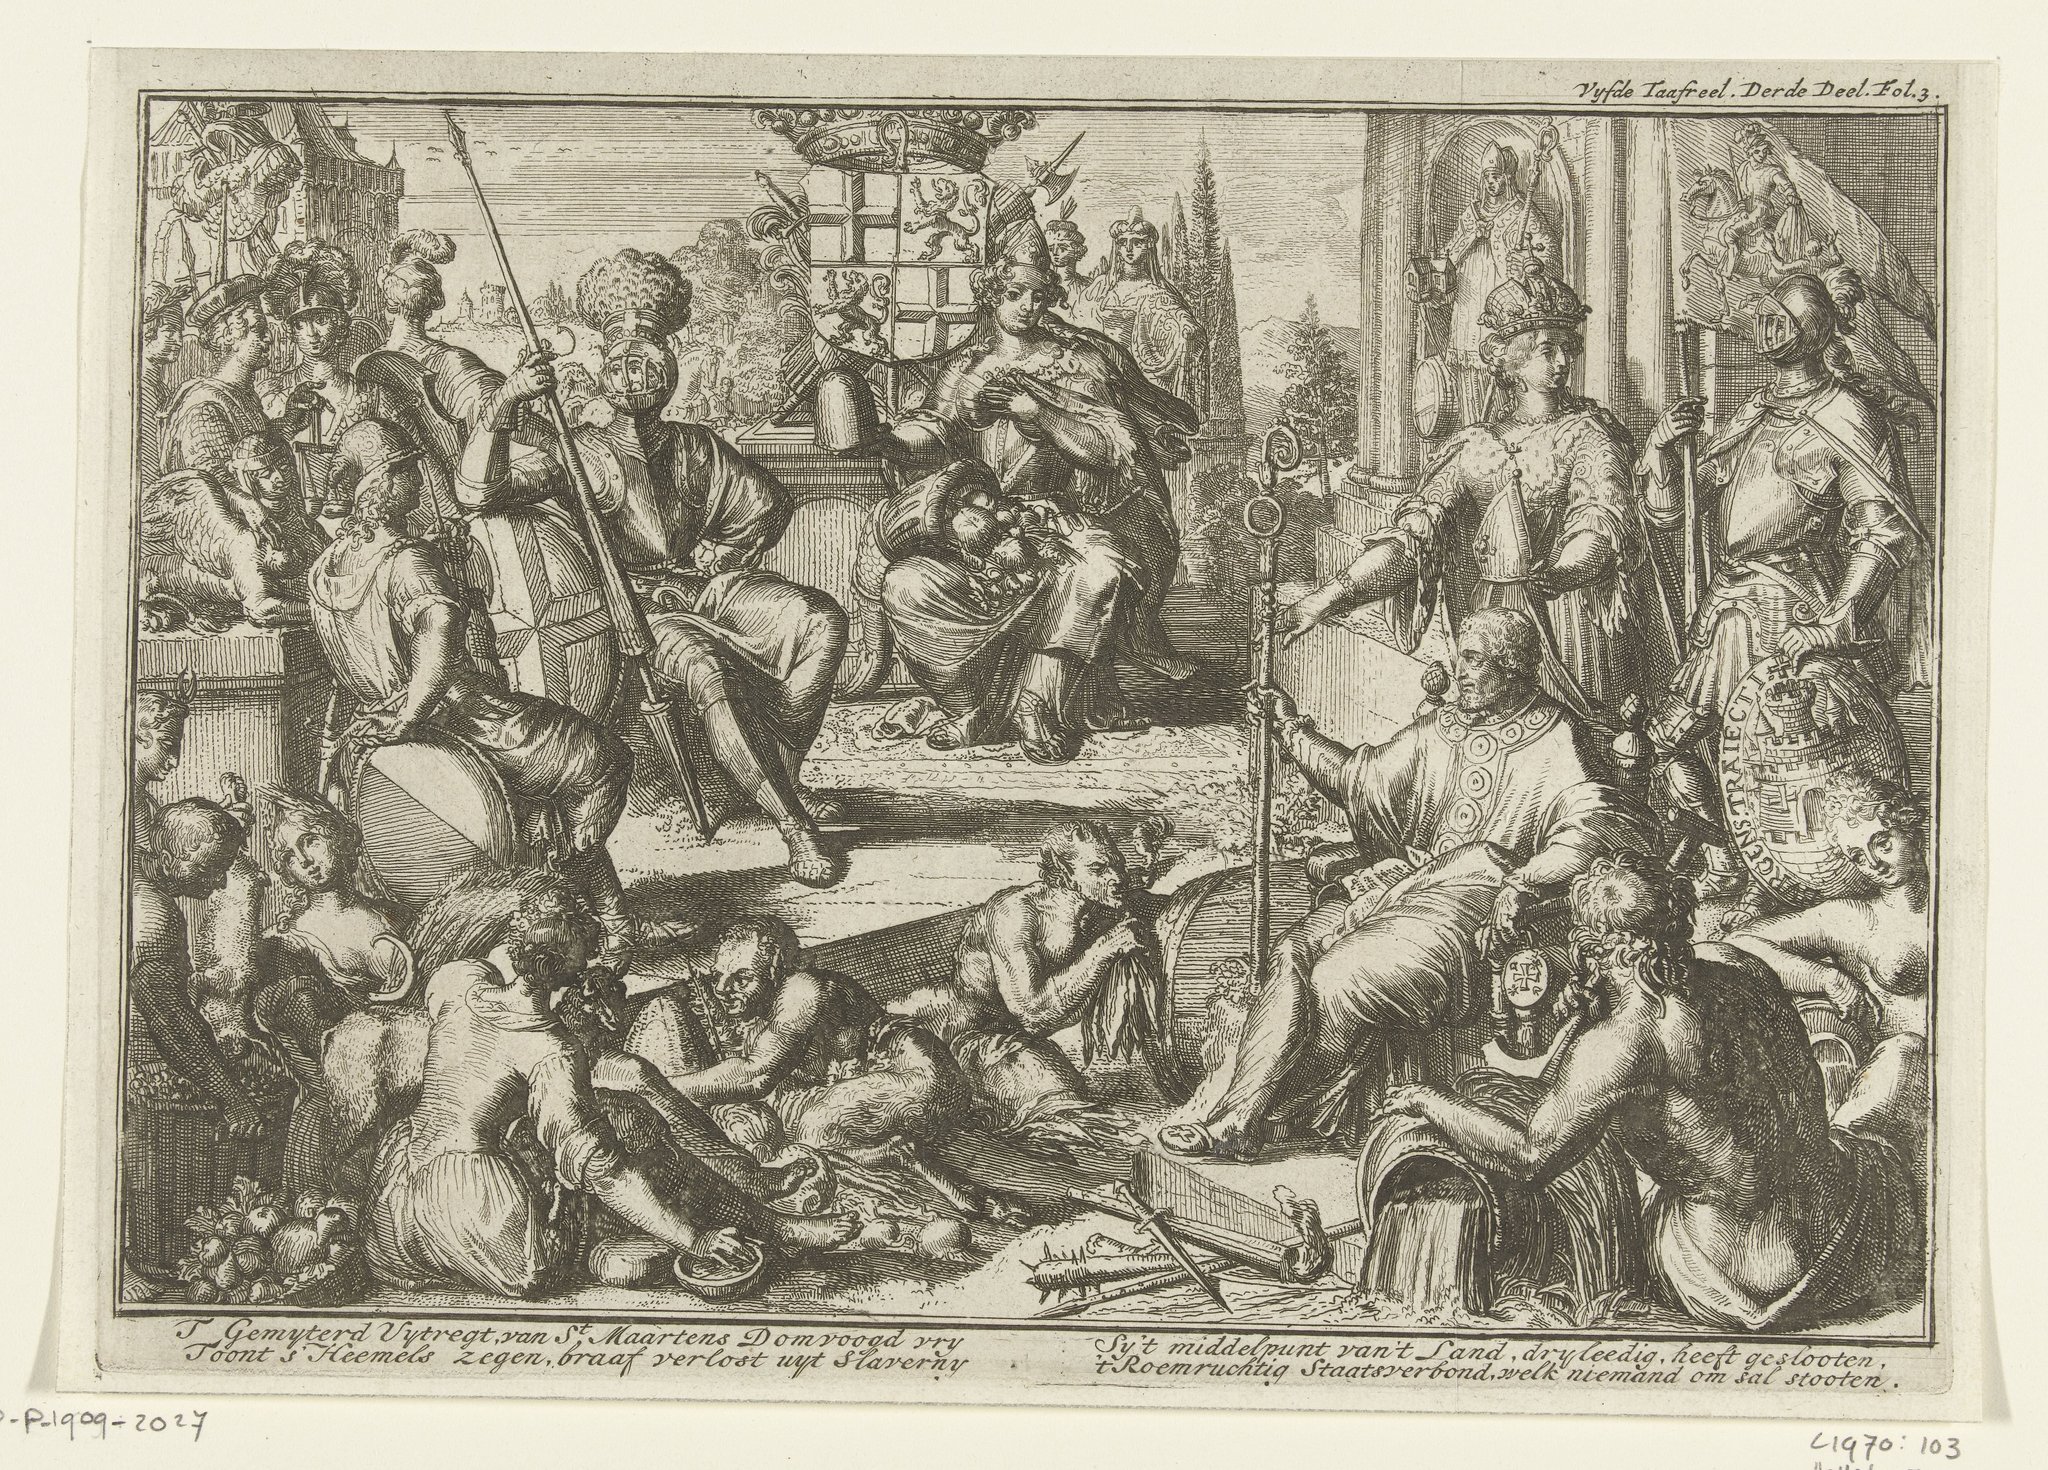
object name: print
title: Allegorie met Utrecht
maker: romeyn de hooghe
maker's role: draughtsman, goldsmith, painter, print maker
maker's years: 1645-1708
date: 1704-1706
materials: paper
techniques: etching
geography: netherlands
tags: personifications of countries, nations, states, districts, etc.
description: Illustratie voor: R. de Hooghe, Spiegel van staat des Vereenigde Nederlands, J. ten Hoorn, Amsterdam 1706, dl. I, vijfde tafereel, p. 3.